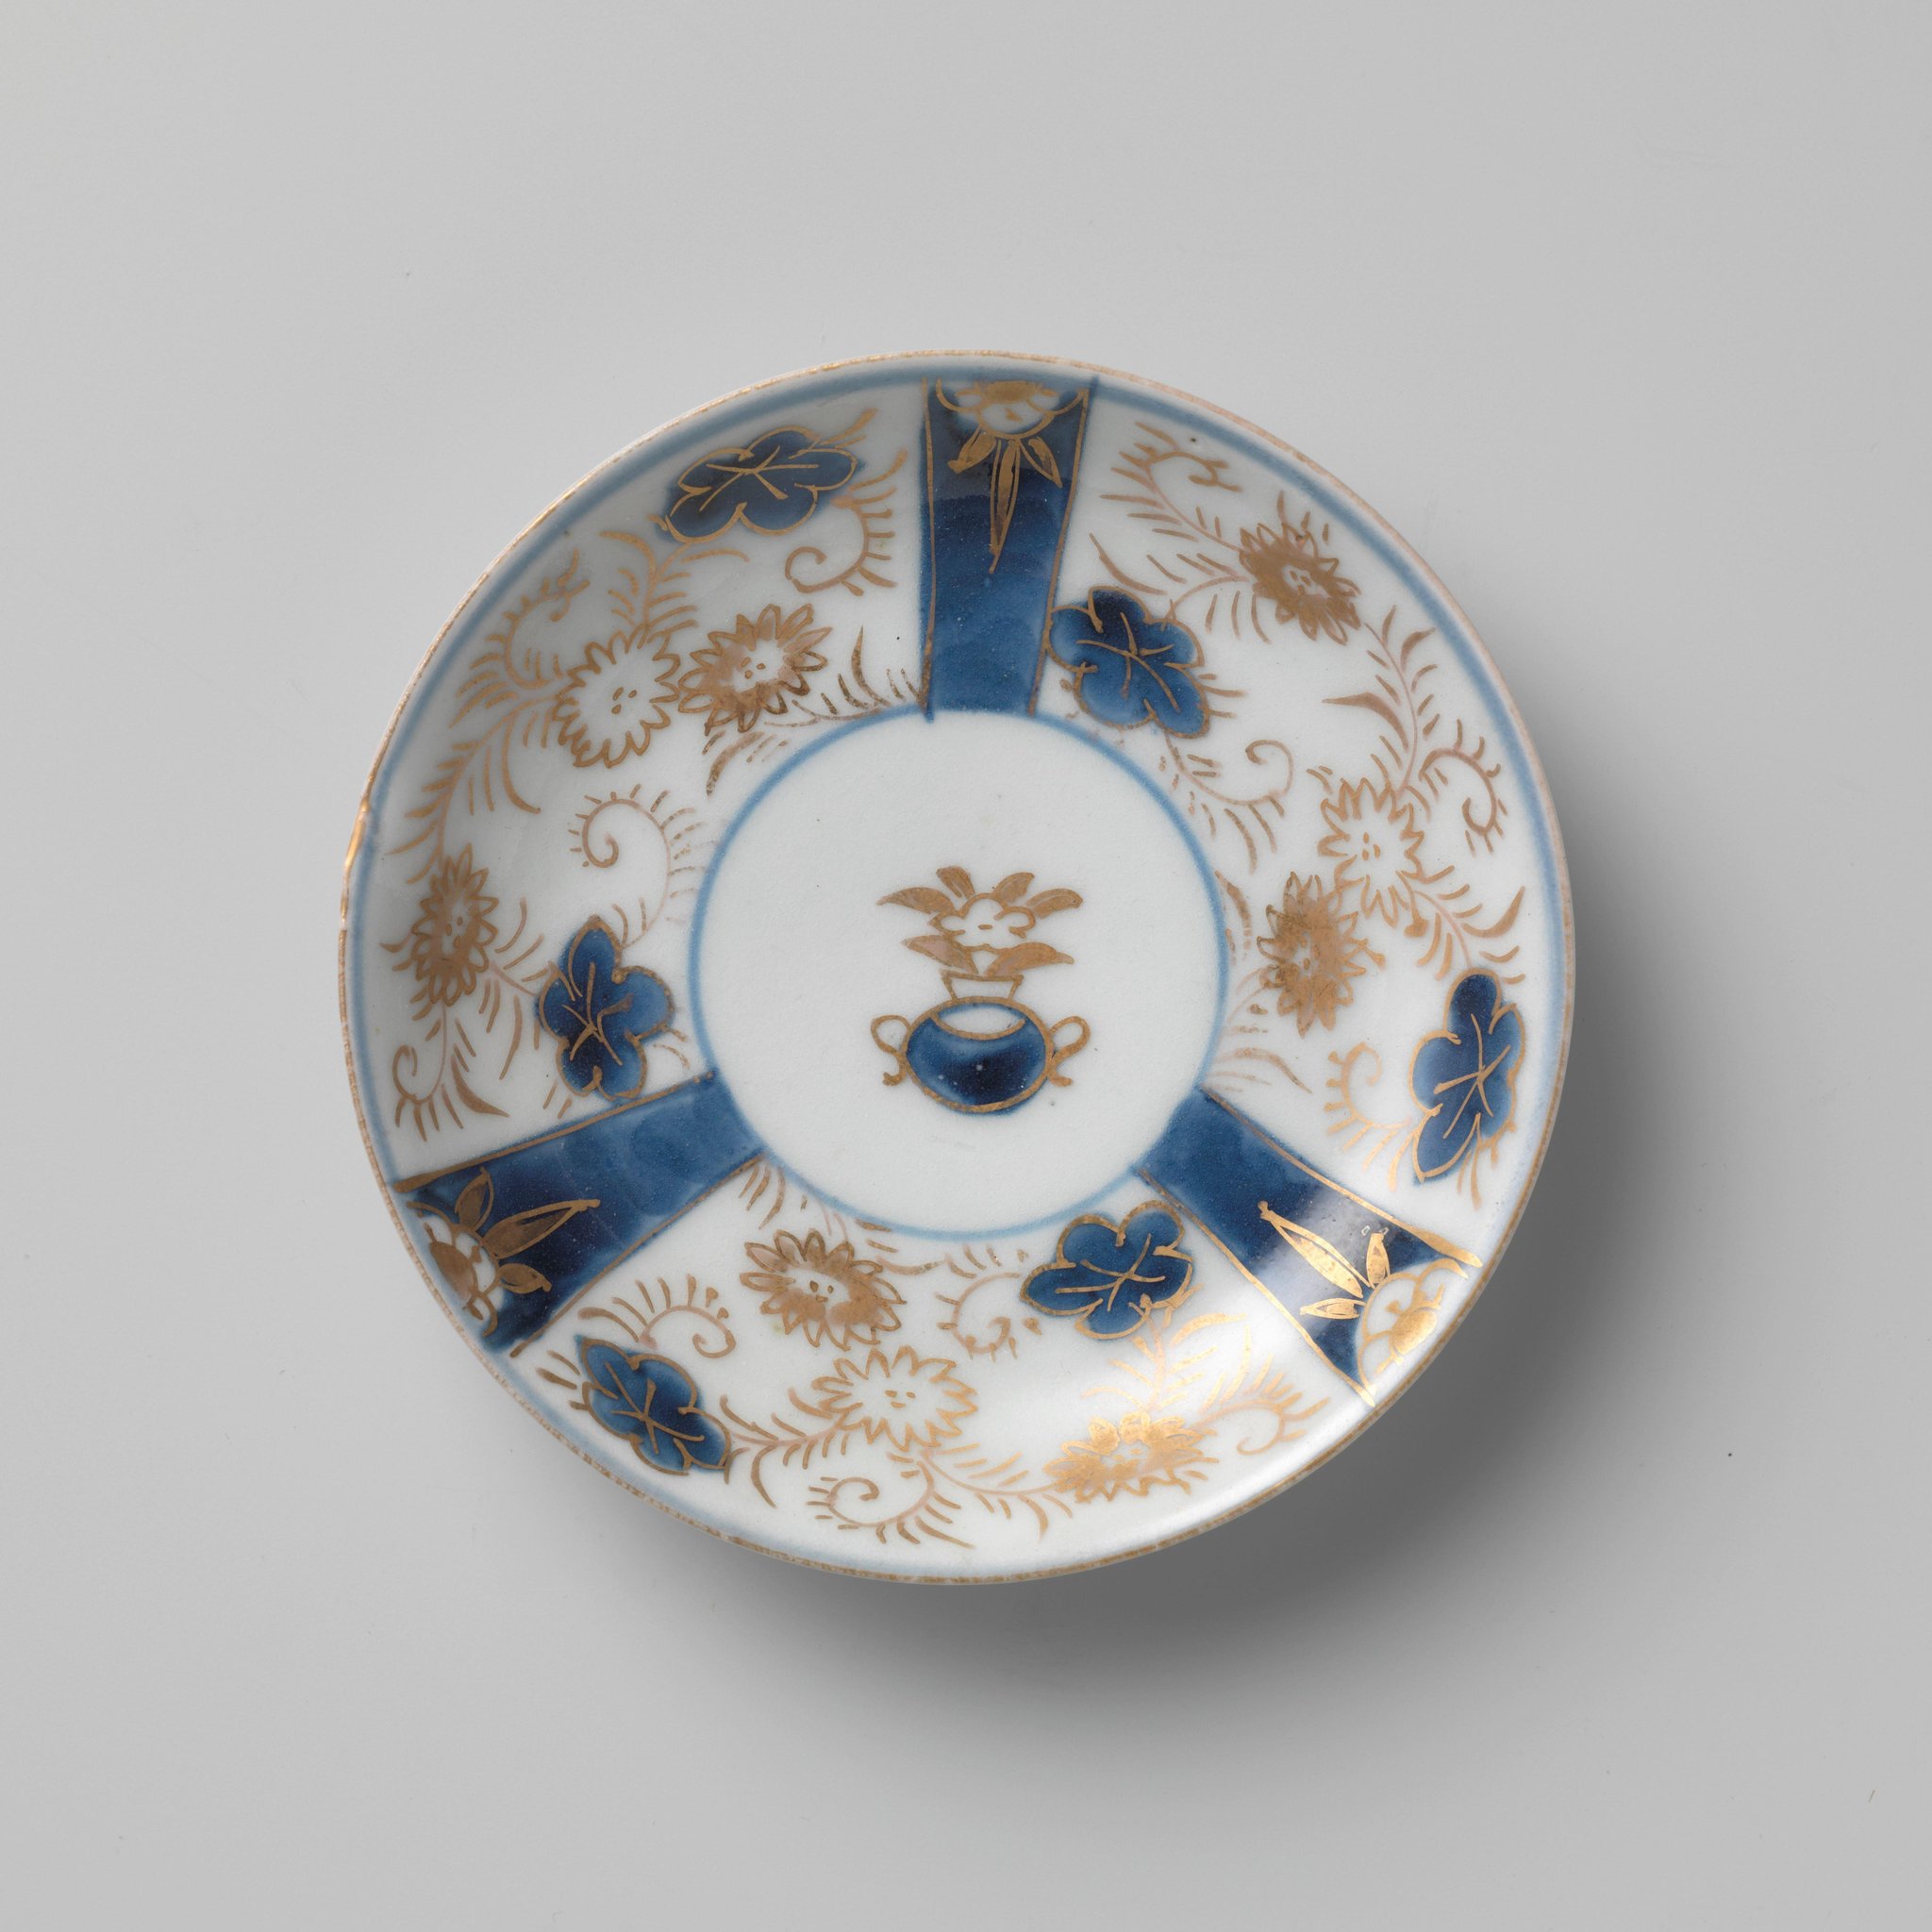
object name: platter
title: Saucer with a flower basket and floral scrolls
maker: Anonymous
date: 1775-1799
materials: cobalt, glaze, gold, paint, porcelain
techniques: firing, gilding, turning, vitrification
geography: japan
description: Schotel van porselein, beschilderd in onderglazuur blauw en op het glazuur goud. Op het plat in een medaillon een bloempot; de wand is verdeeld in drie waaiervormige vakken gescheiden door een brede streep met een bloem. In de vakken bloemranken. Imari.